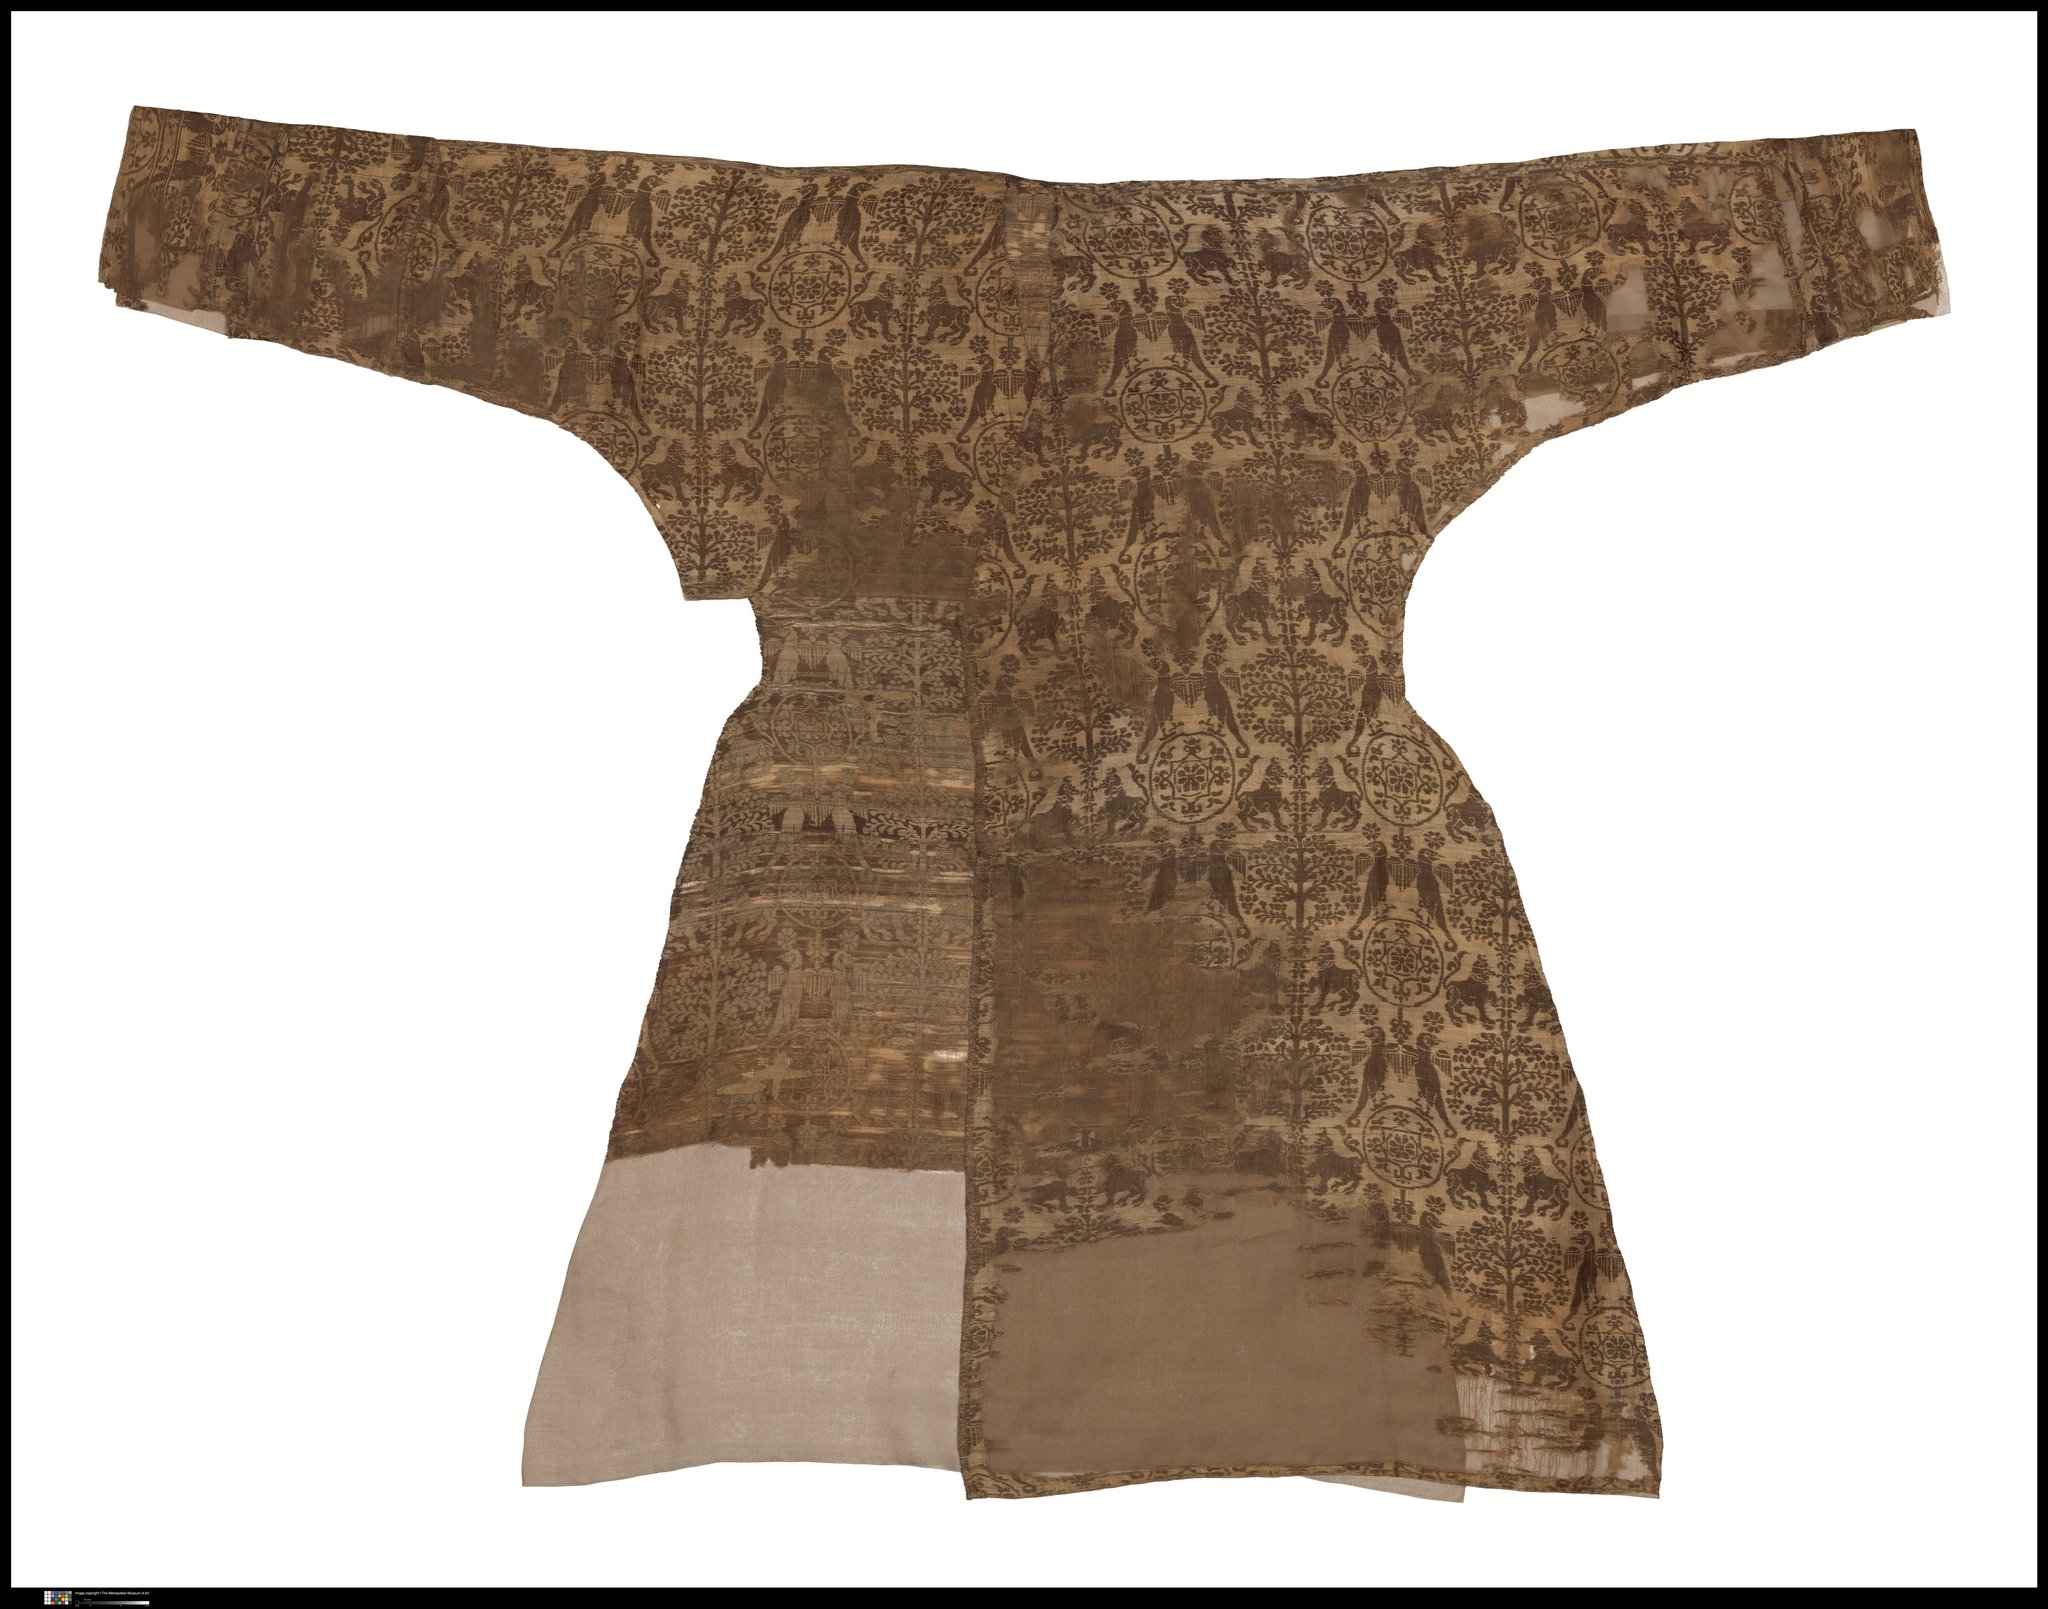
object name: coat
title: Riding Coat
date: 1201-1250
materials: silk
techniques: weave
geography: iran